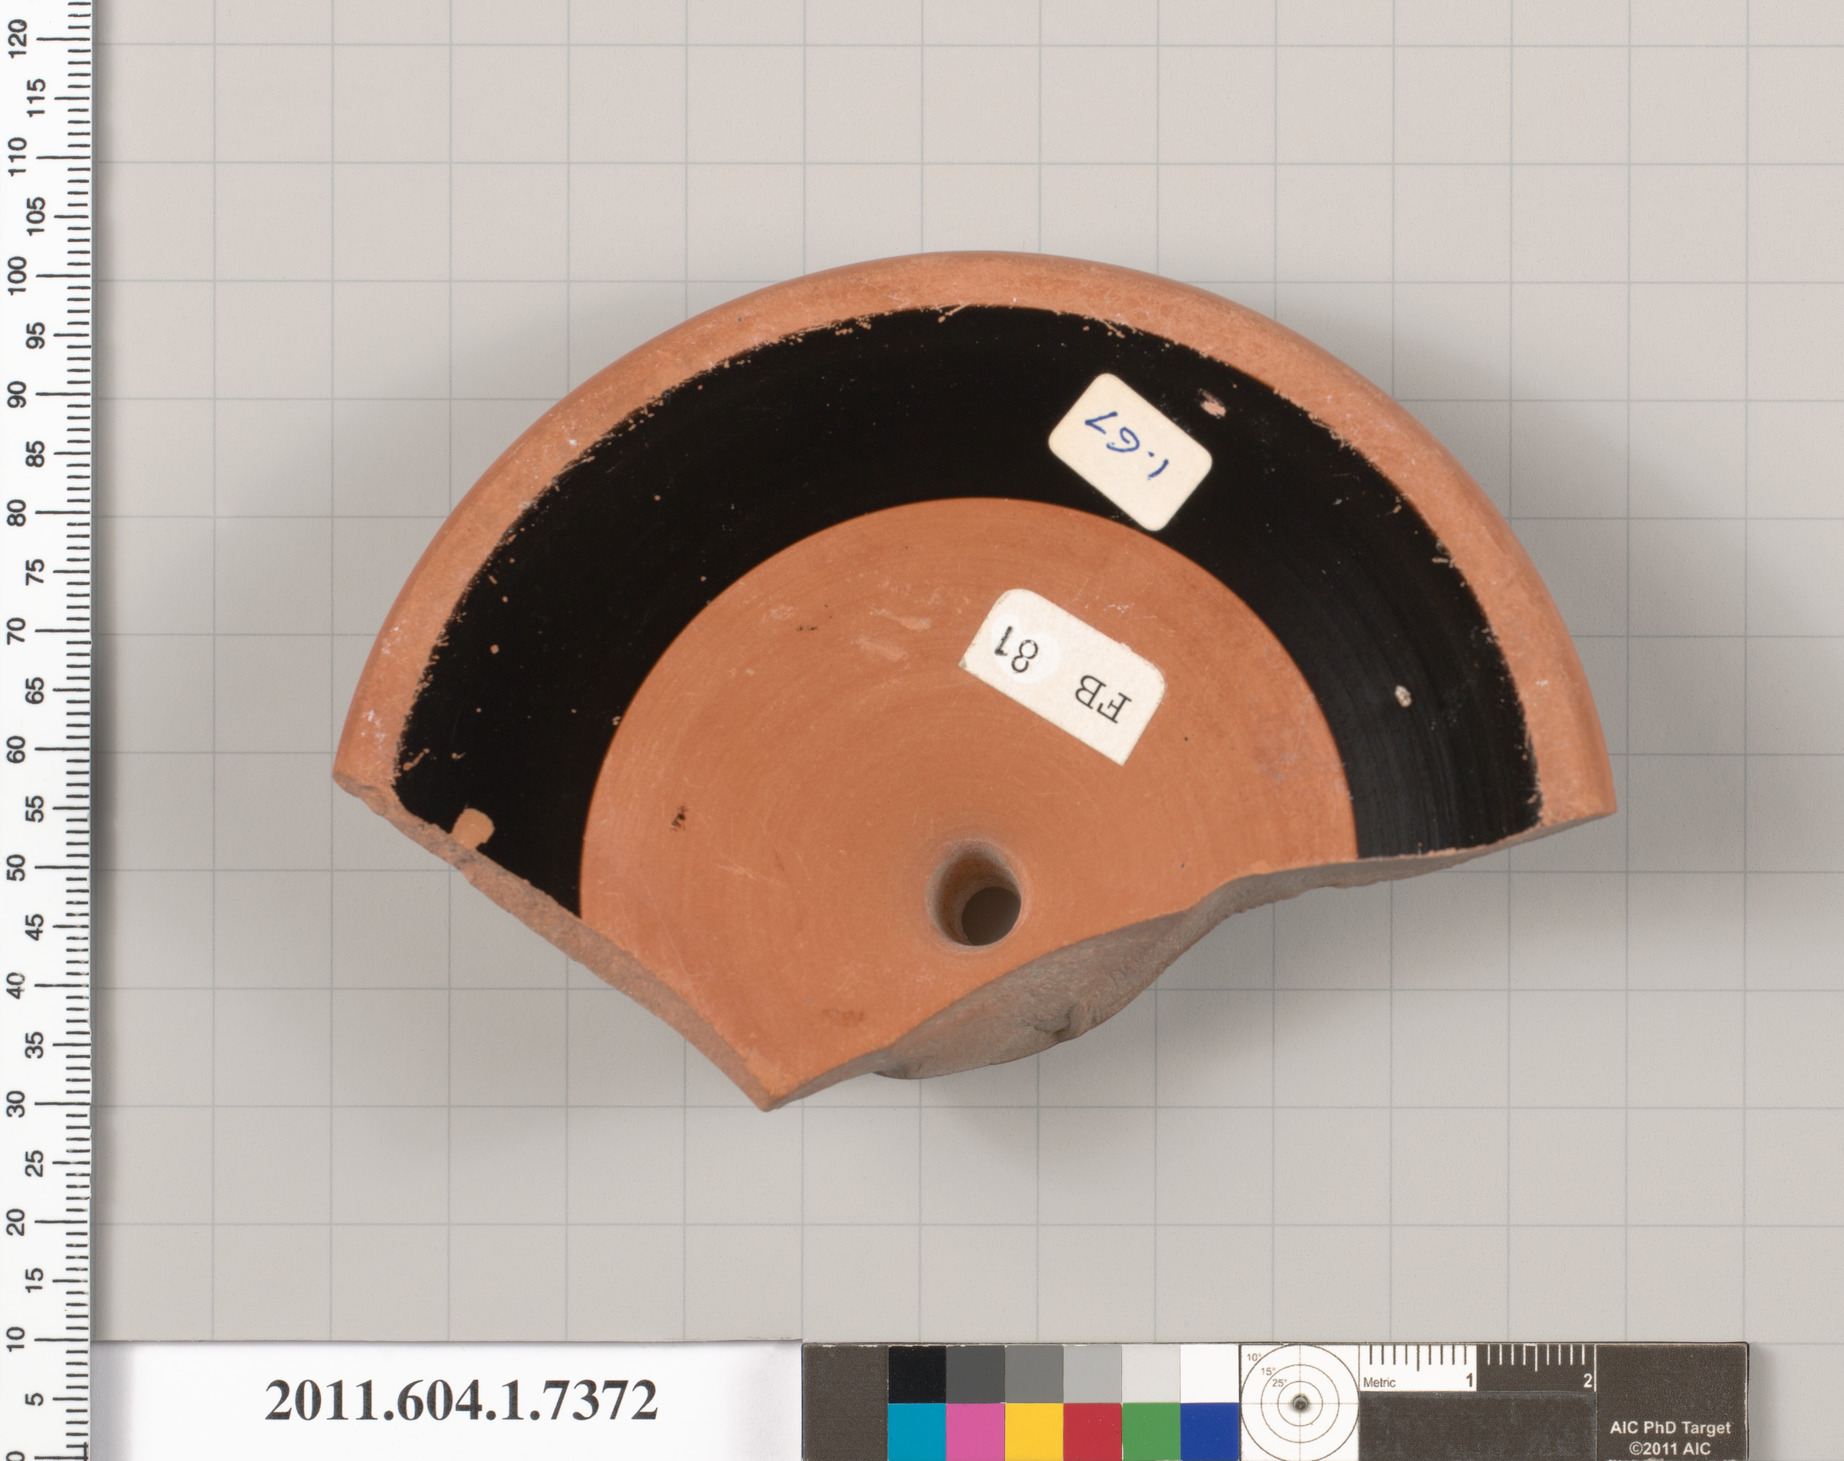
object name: kylix fragment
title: Terracotta fragment of a kylix (drinking cup)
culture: greek, attic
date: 500-480 BCE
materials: terracotta